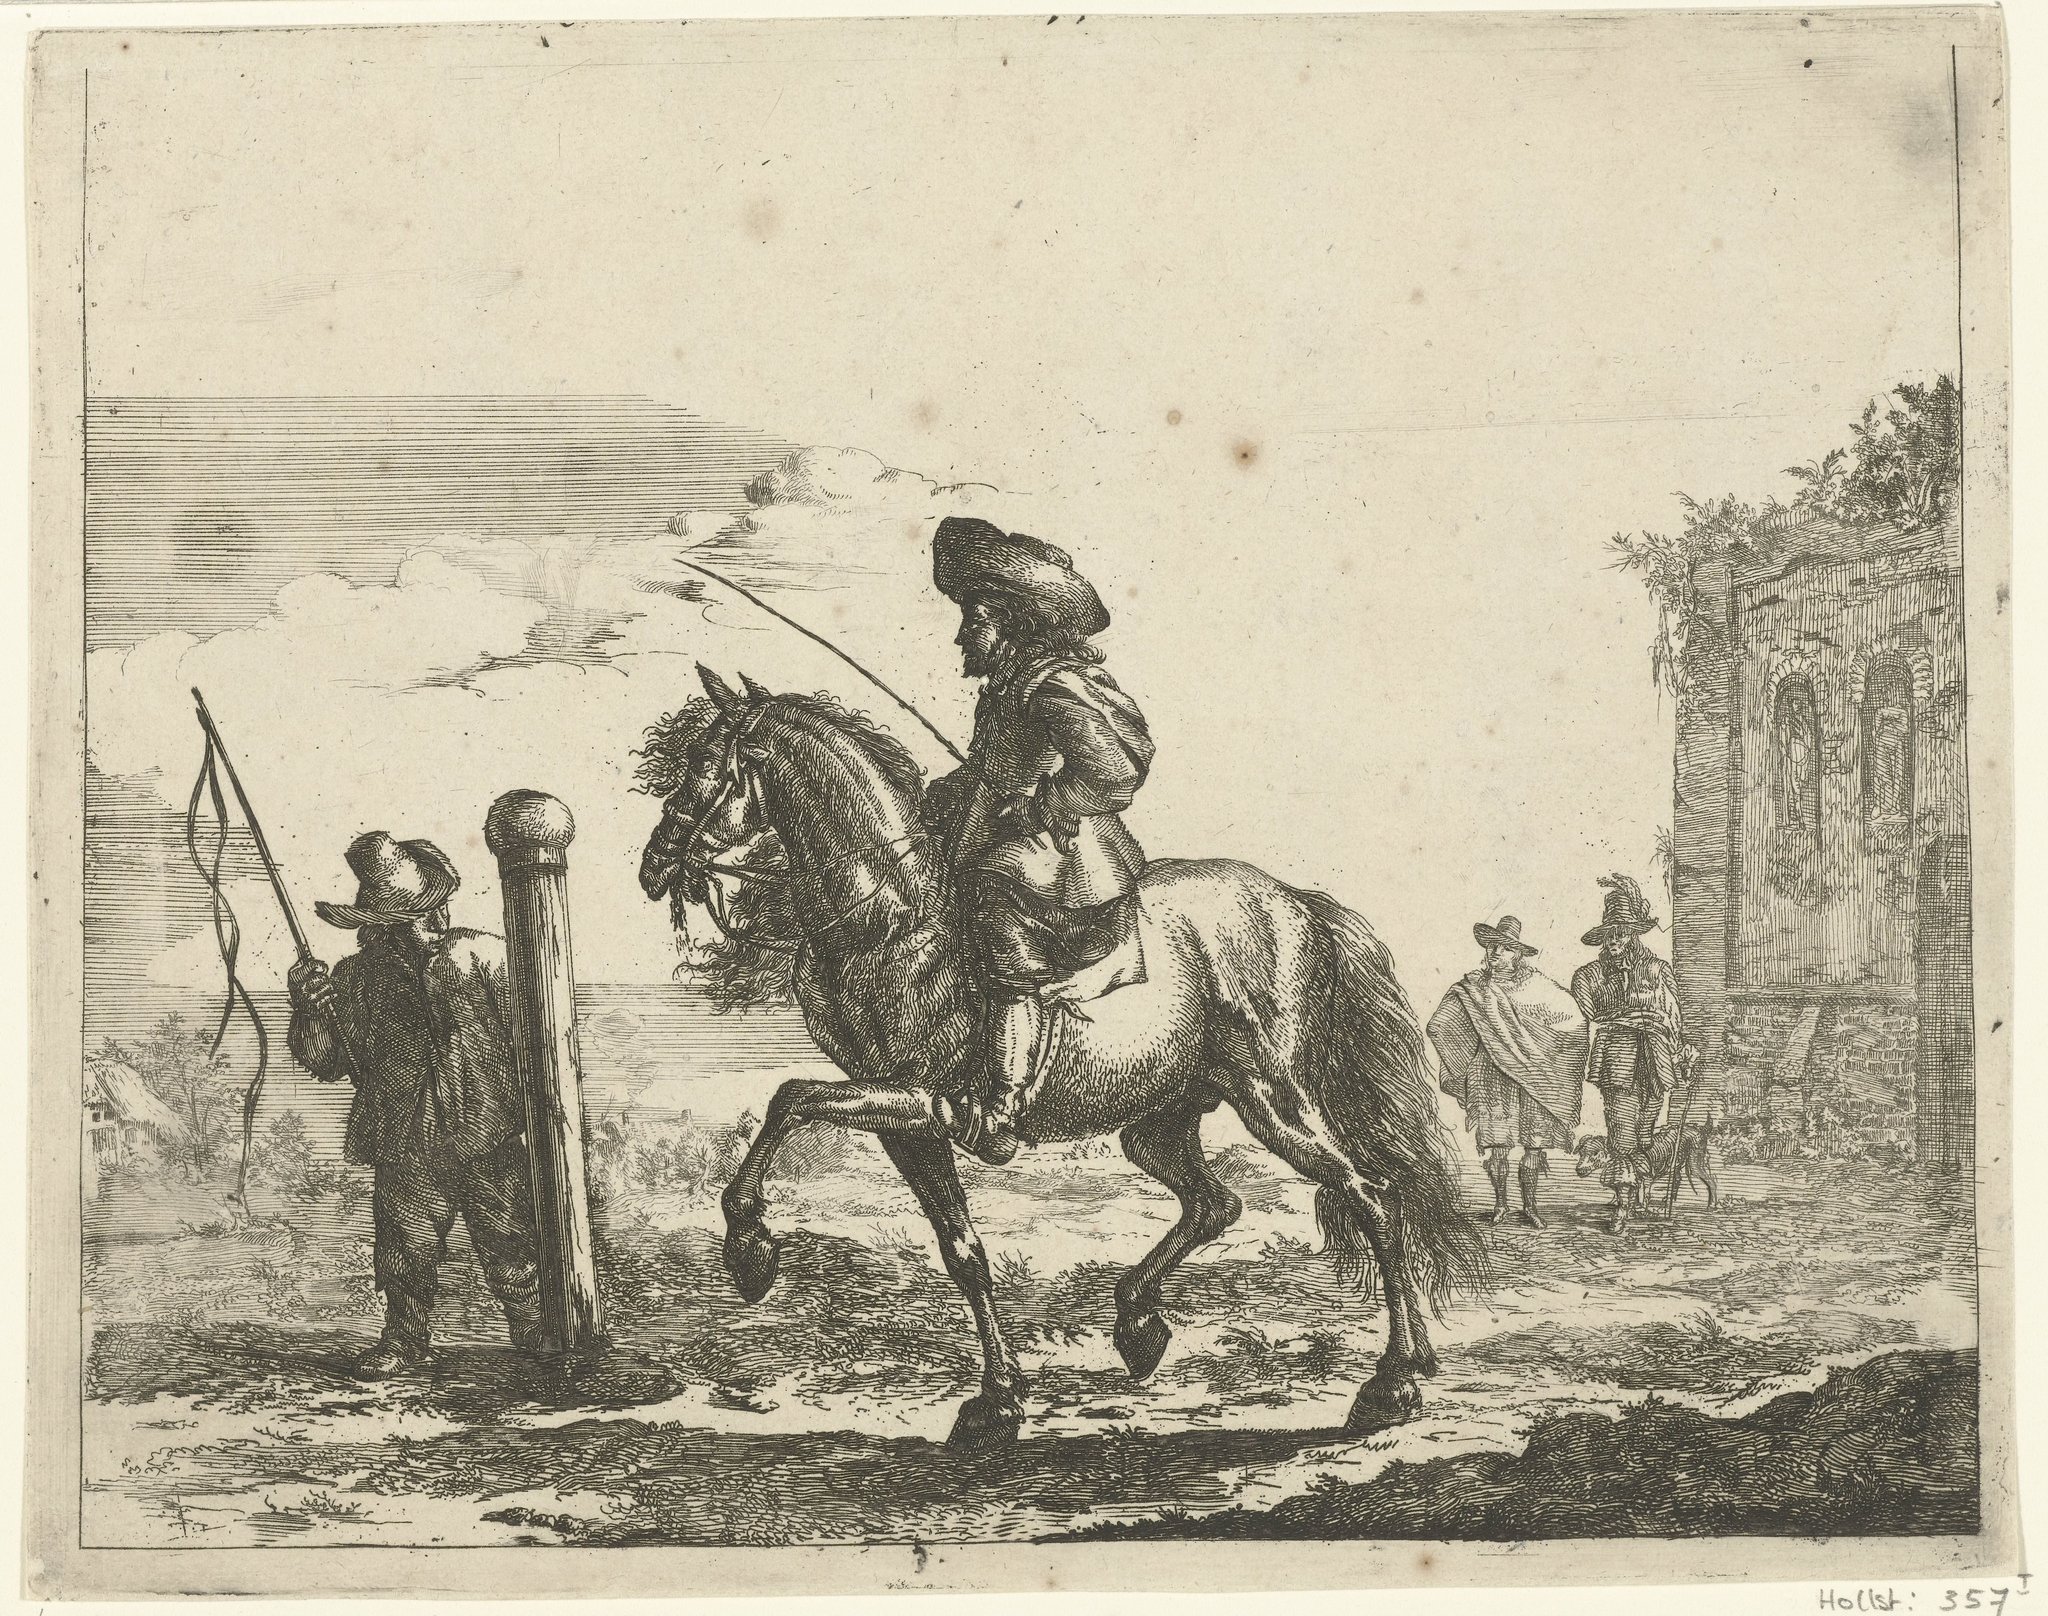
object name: print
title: Ruiter met links een knecht en rechts een ruïne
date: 1655-1667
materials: paper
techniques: etching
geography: netherlands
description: Ruiter met links een knecht en rechts een ruïne